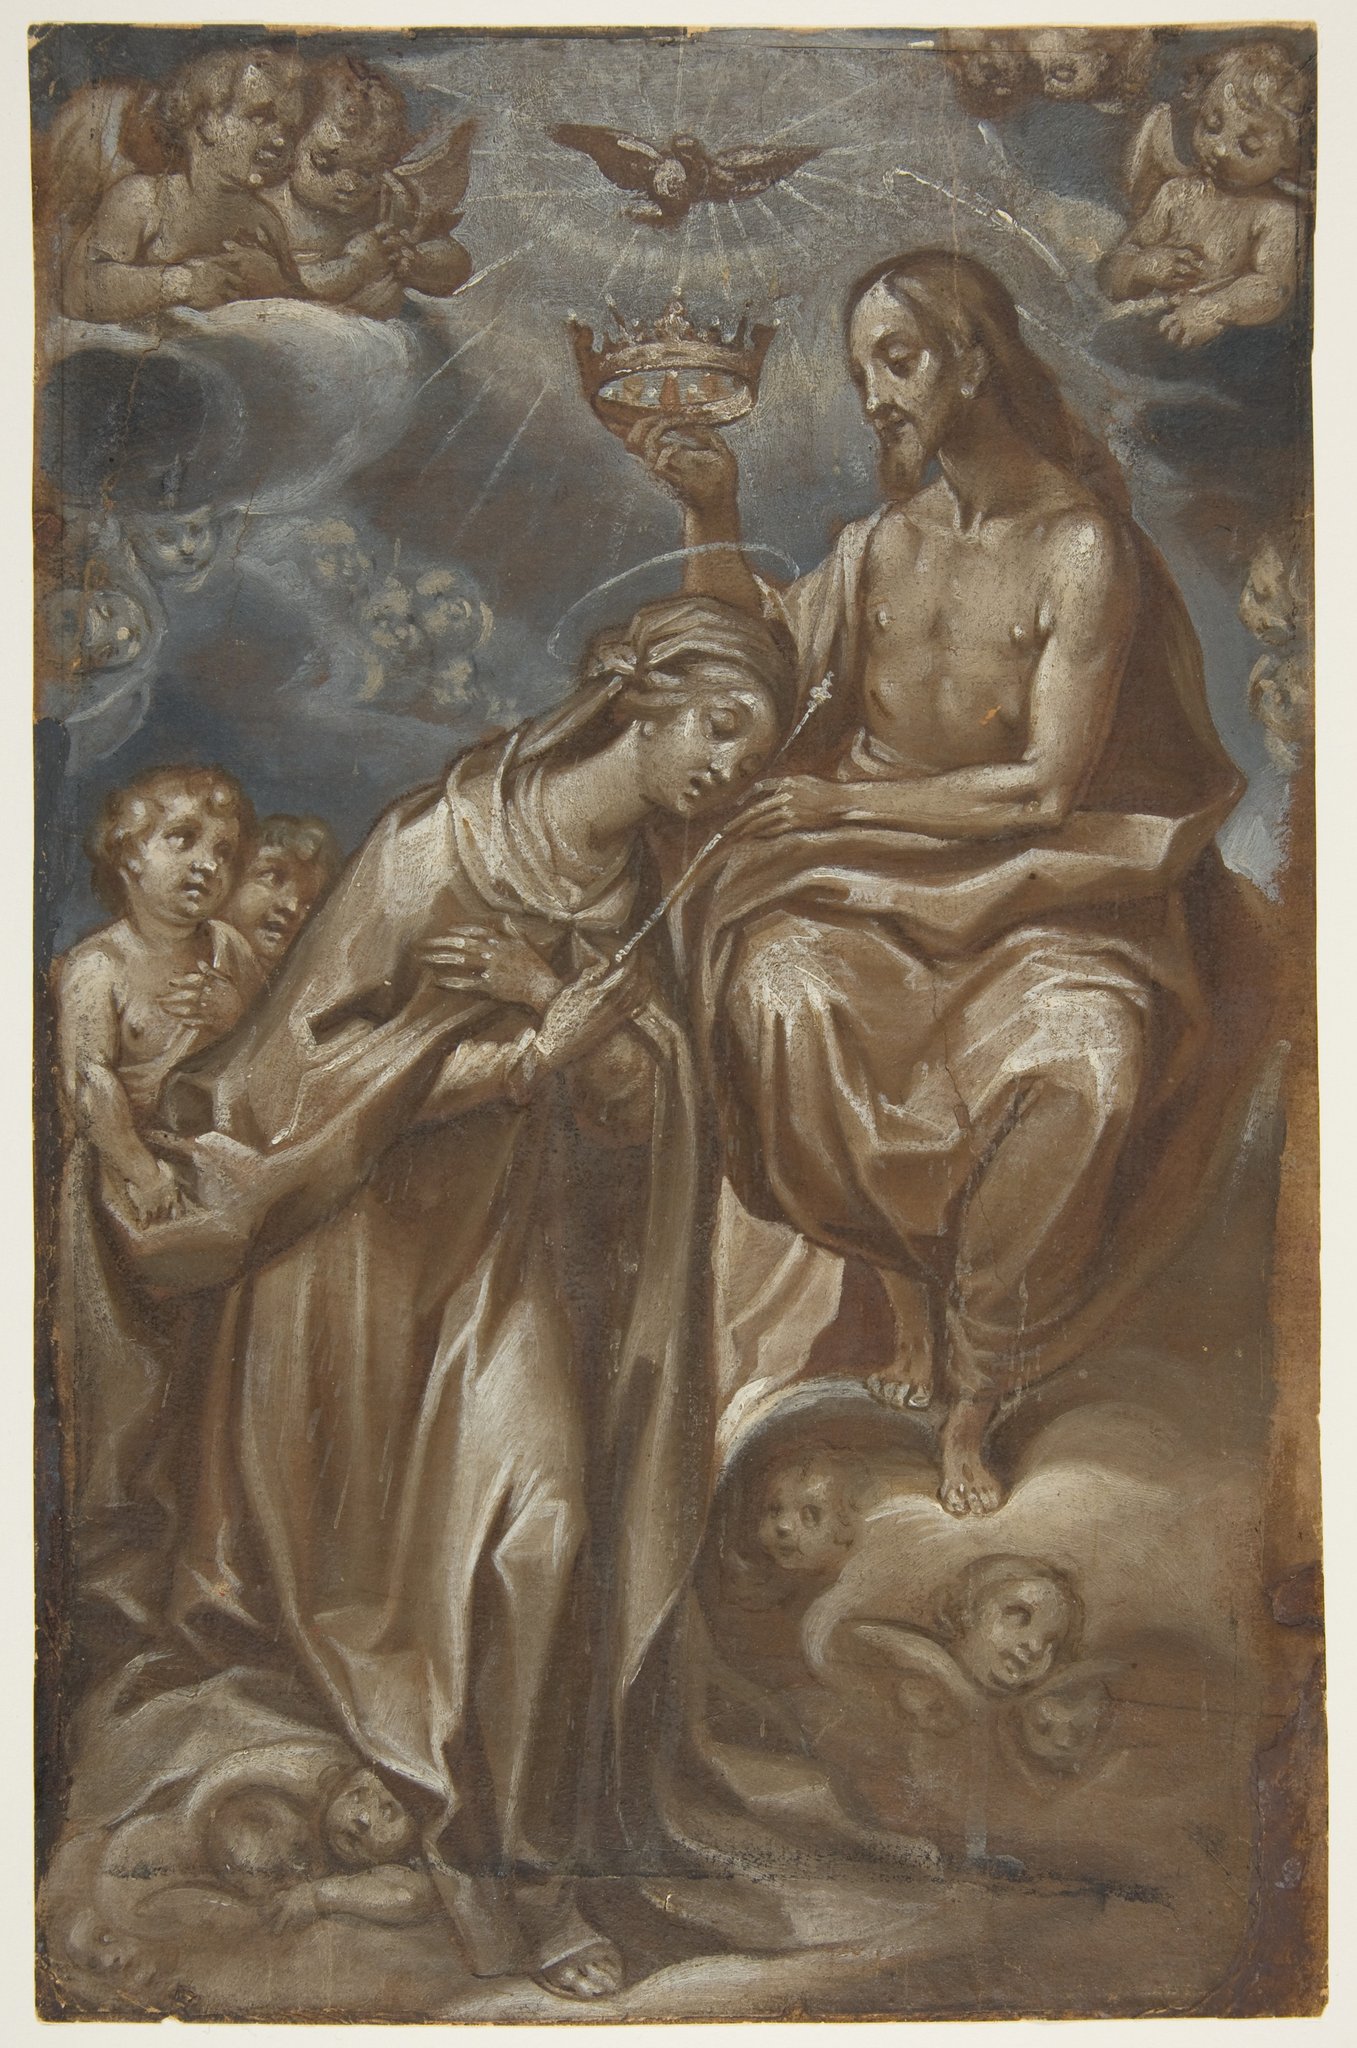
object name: drawing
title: The Coronation of the Virgin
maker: francesco vanni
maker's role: artist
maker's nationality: italian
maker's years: 1563-1610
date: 1605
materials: paper, paint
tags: birds,angels,christ,virgin mary